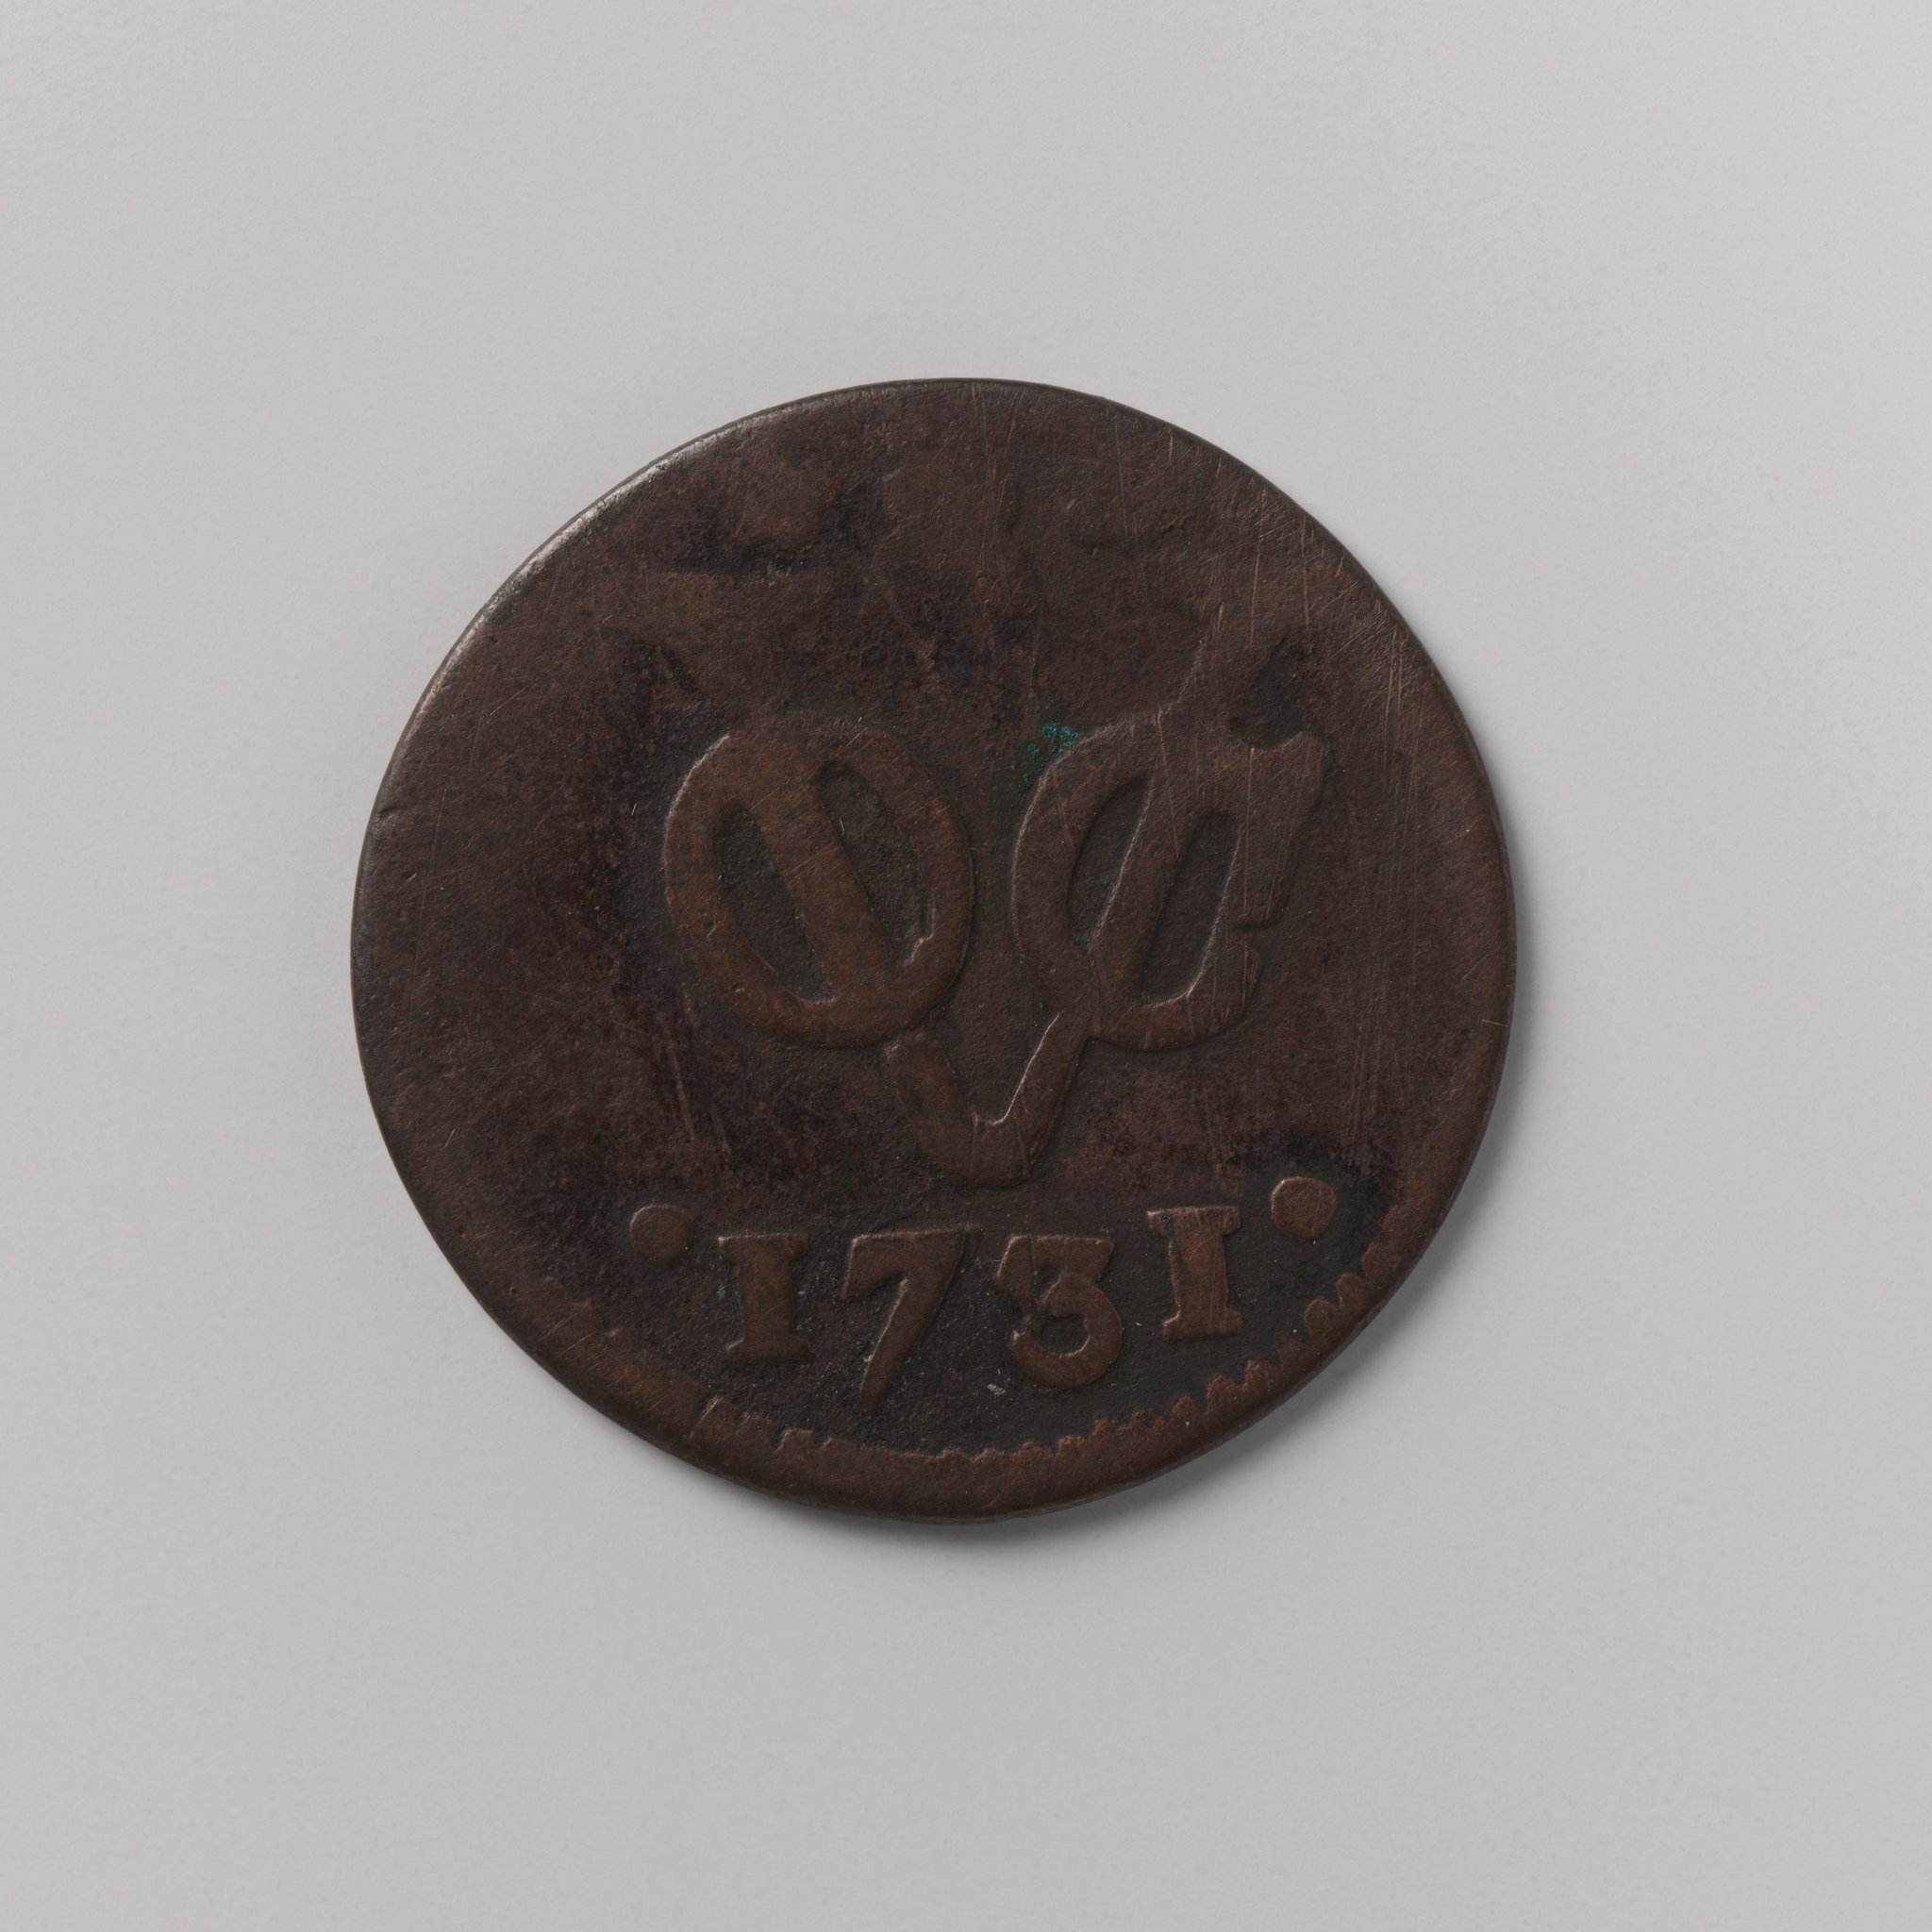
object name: coin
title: Duit van de VOC uit Zeeland, 1731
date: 1731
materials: copper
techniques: striking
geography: middelburg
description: Koperen munt. Voorzijde: gekroond wapenschild van Zeeland. Keerzijde: monogram van de VOC, waarboven muntteken en waaronder jaartal. Gladde rand.